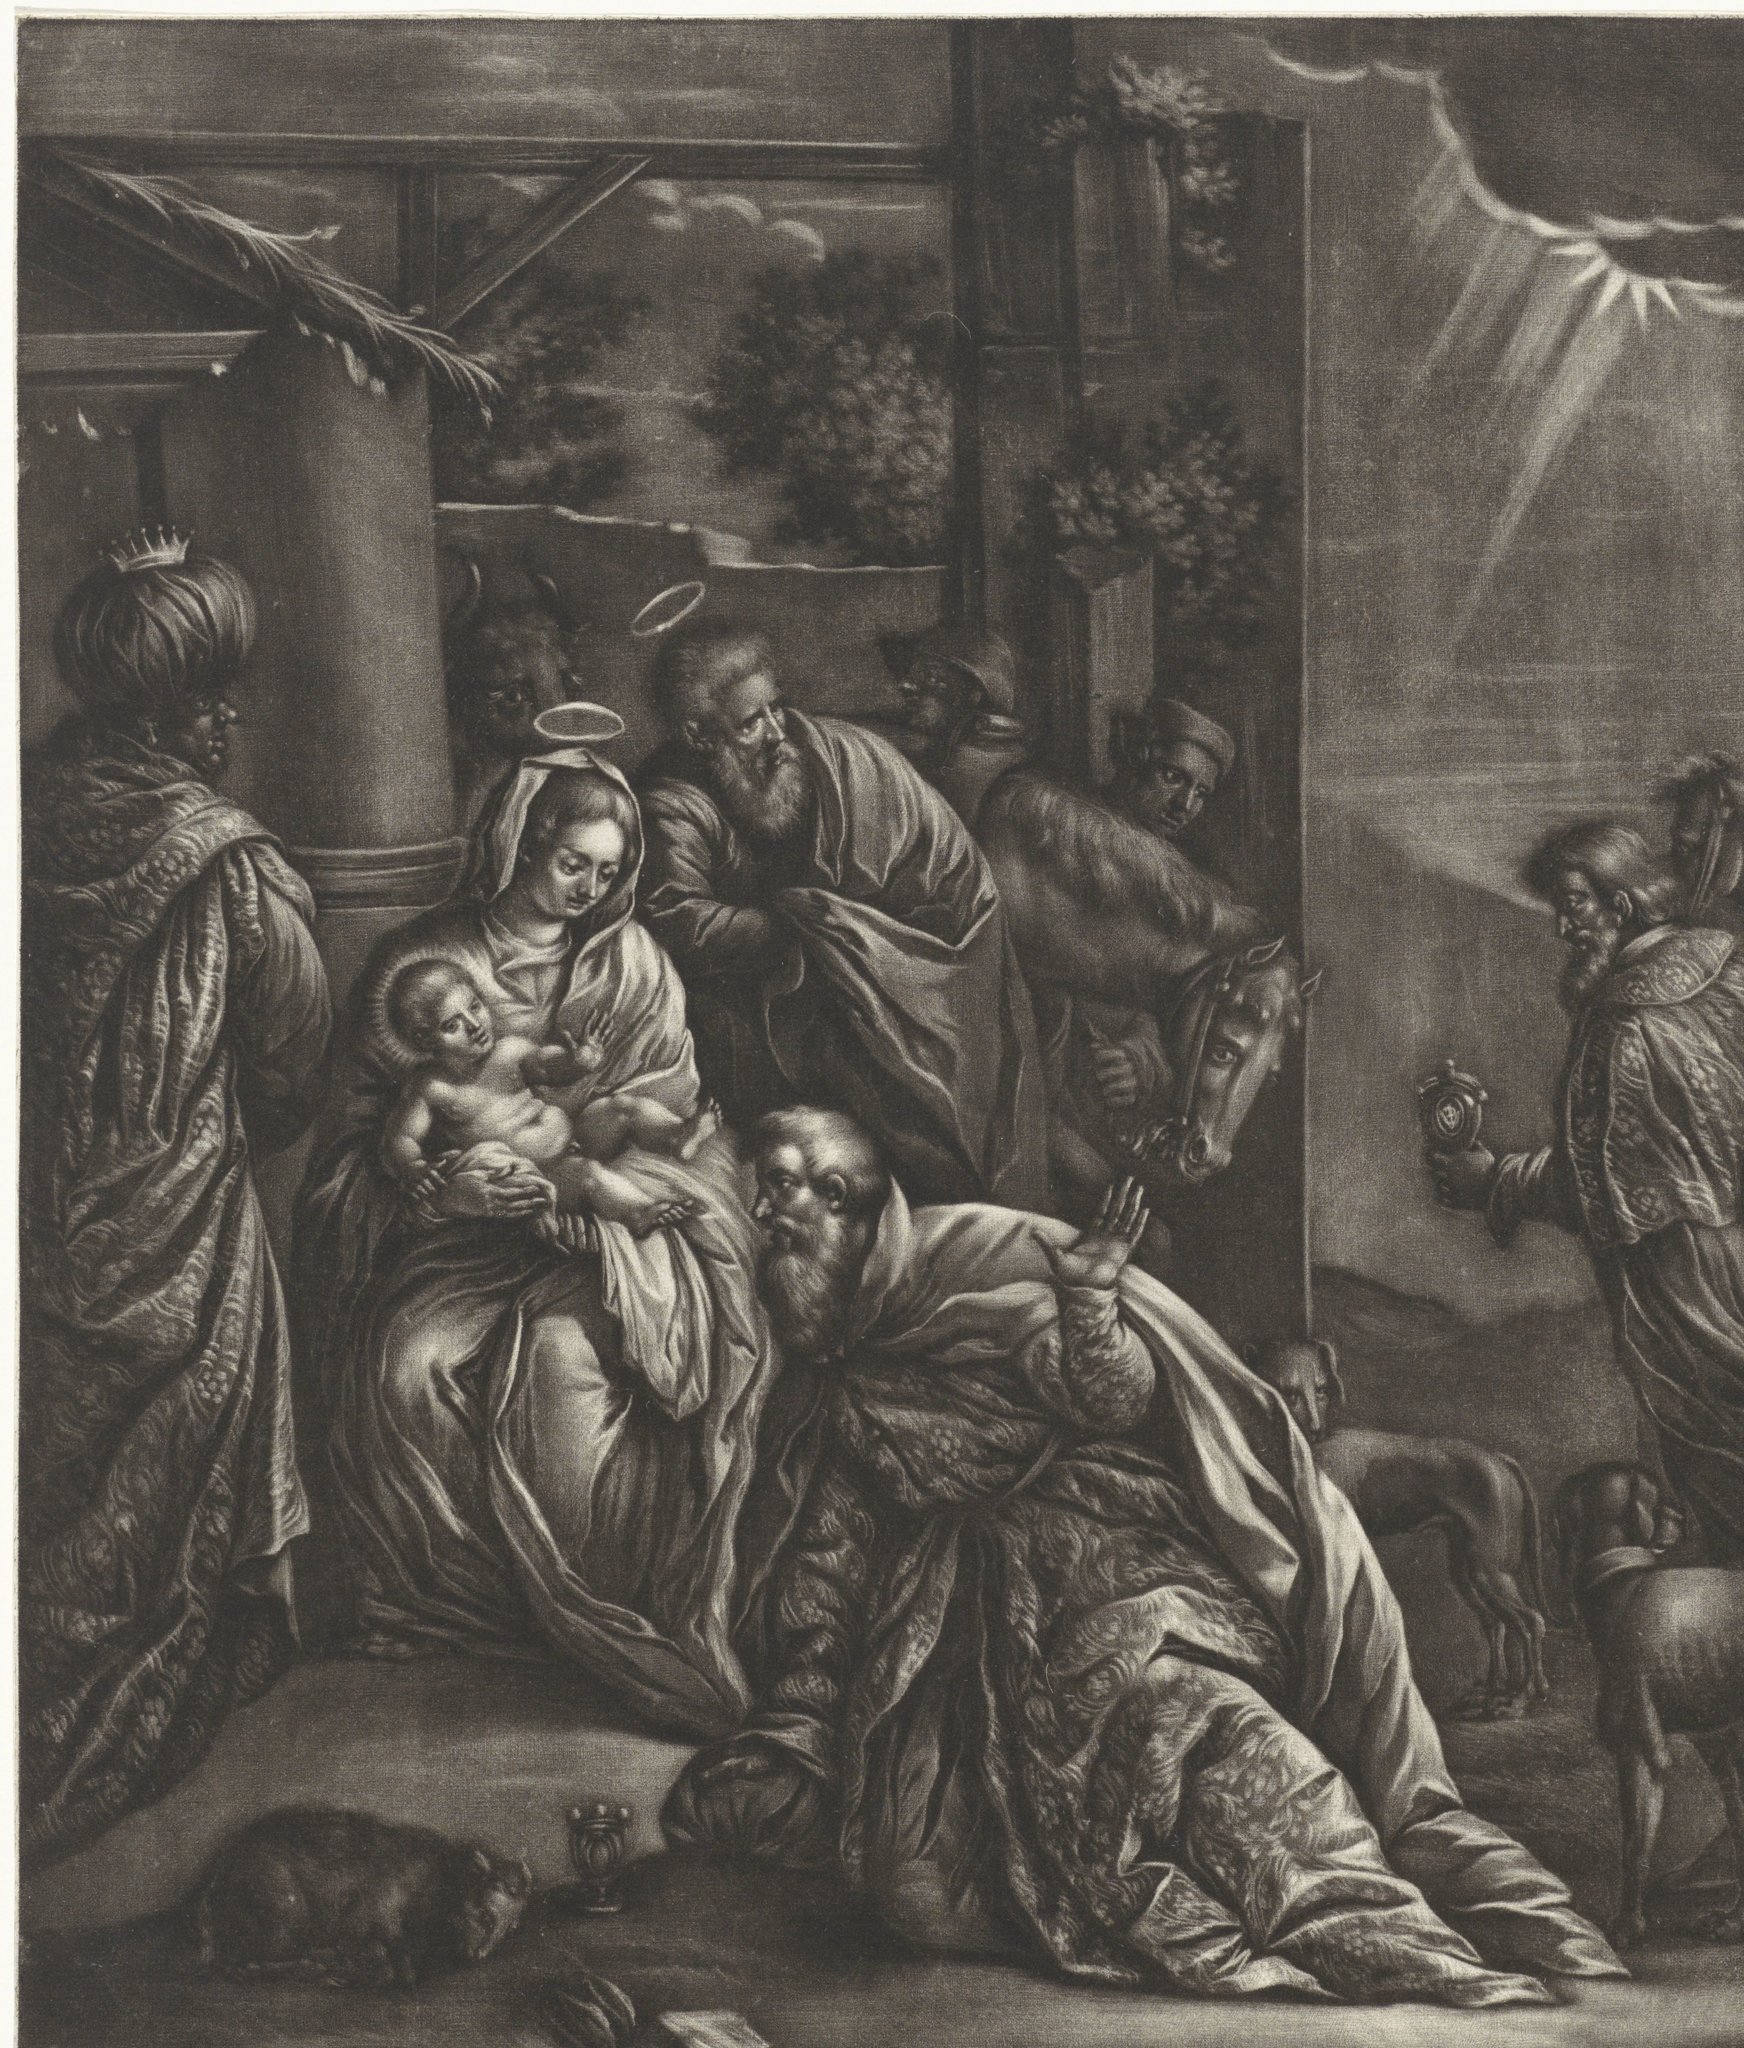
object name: print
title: Aanbidding der koningen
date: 1655-1700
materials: paper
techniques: mezzotint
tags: adoration of the kings: the wise men present their gifts to the christ-child (gold, frankincense and myrrh)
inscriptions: collector's mark: Lugt 2228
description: Het Christuskind wordt, in het bijzijn van Maria en Jozef, aanbeden door de drie Wijzen uit het Oosten die zich met hun geschenken voor het Kind hebben opgesteld.